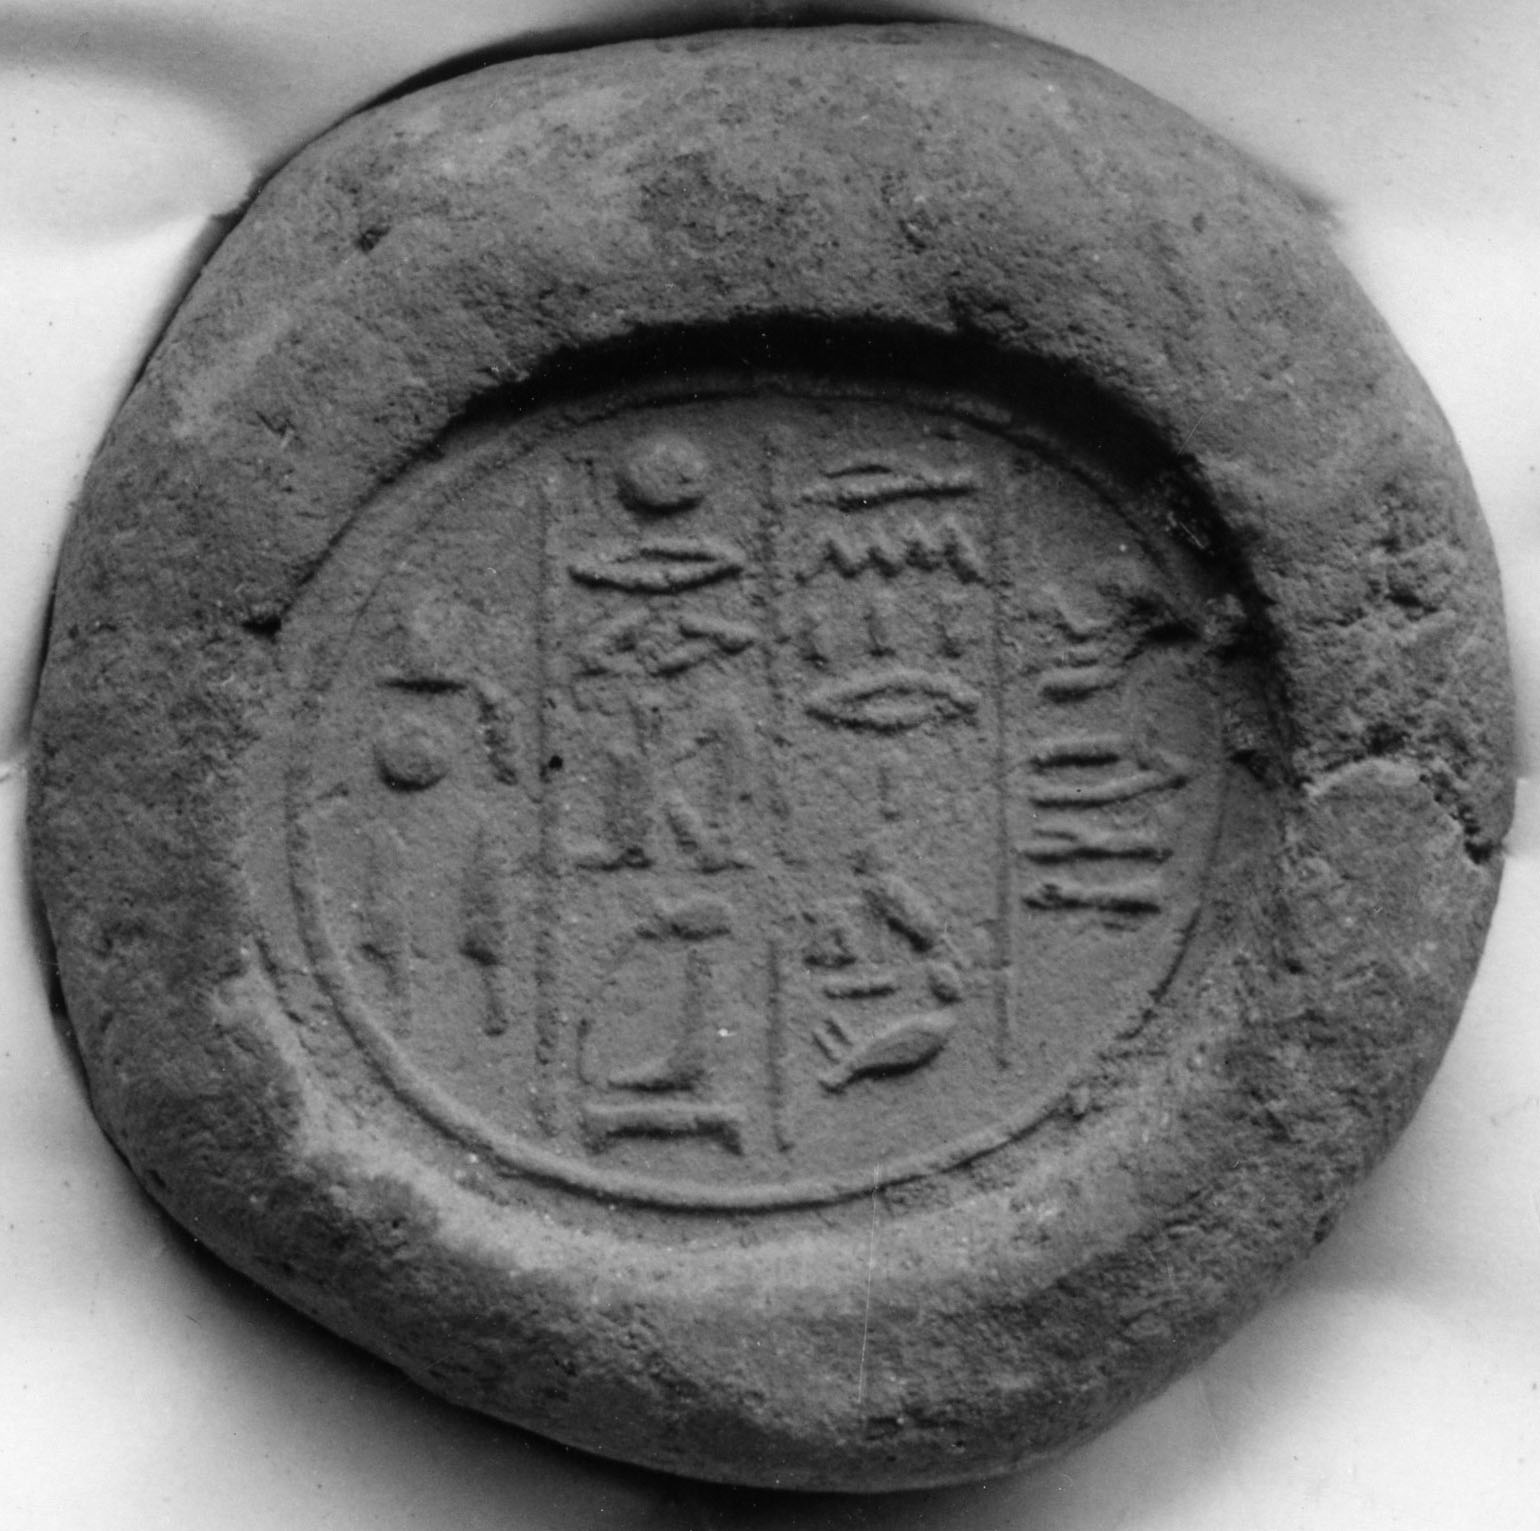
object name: cone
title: Funerary Cones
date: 1550-1295 BCE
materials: pottery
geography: egypt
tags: hieroglyphs